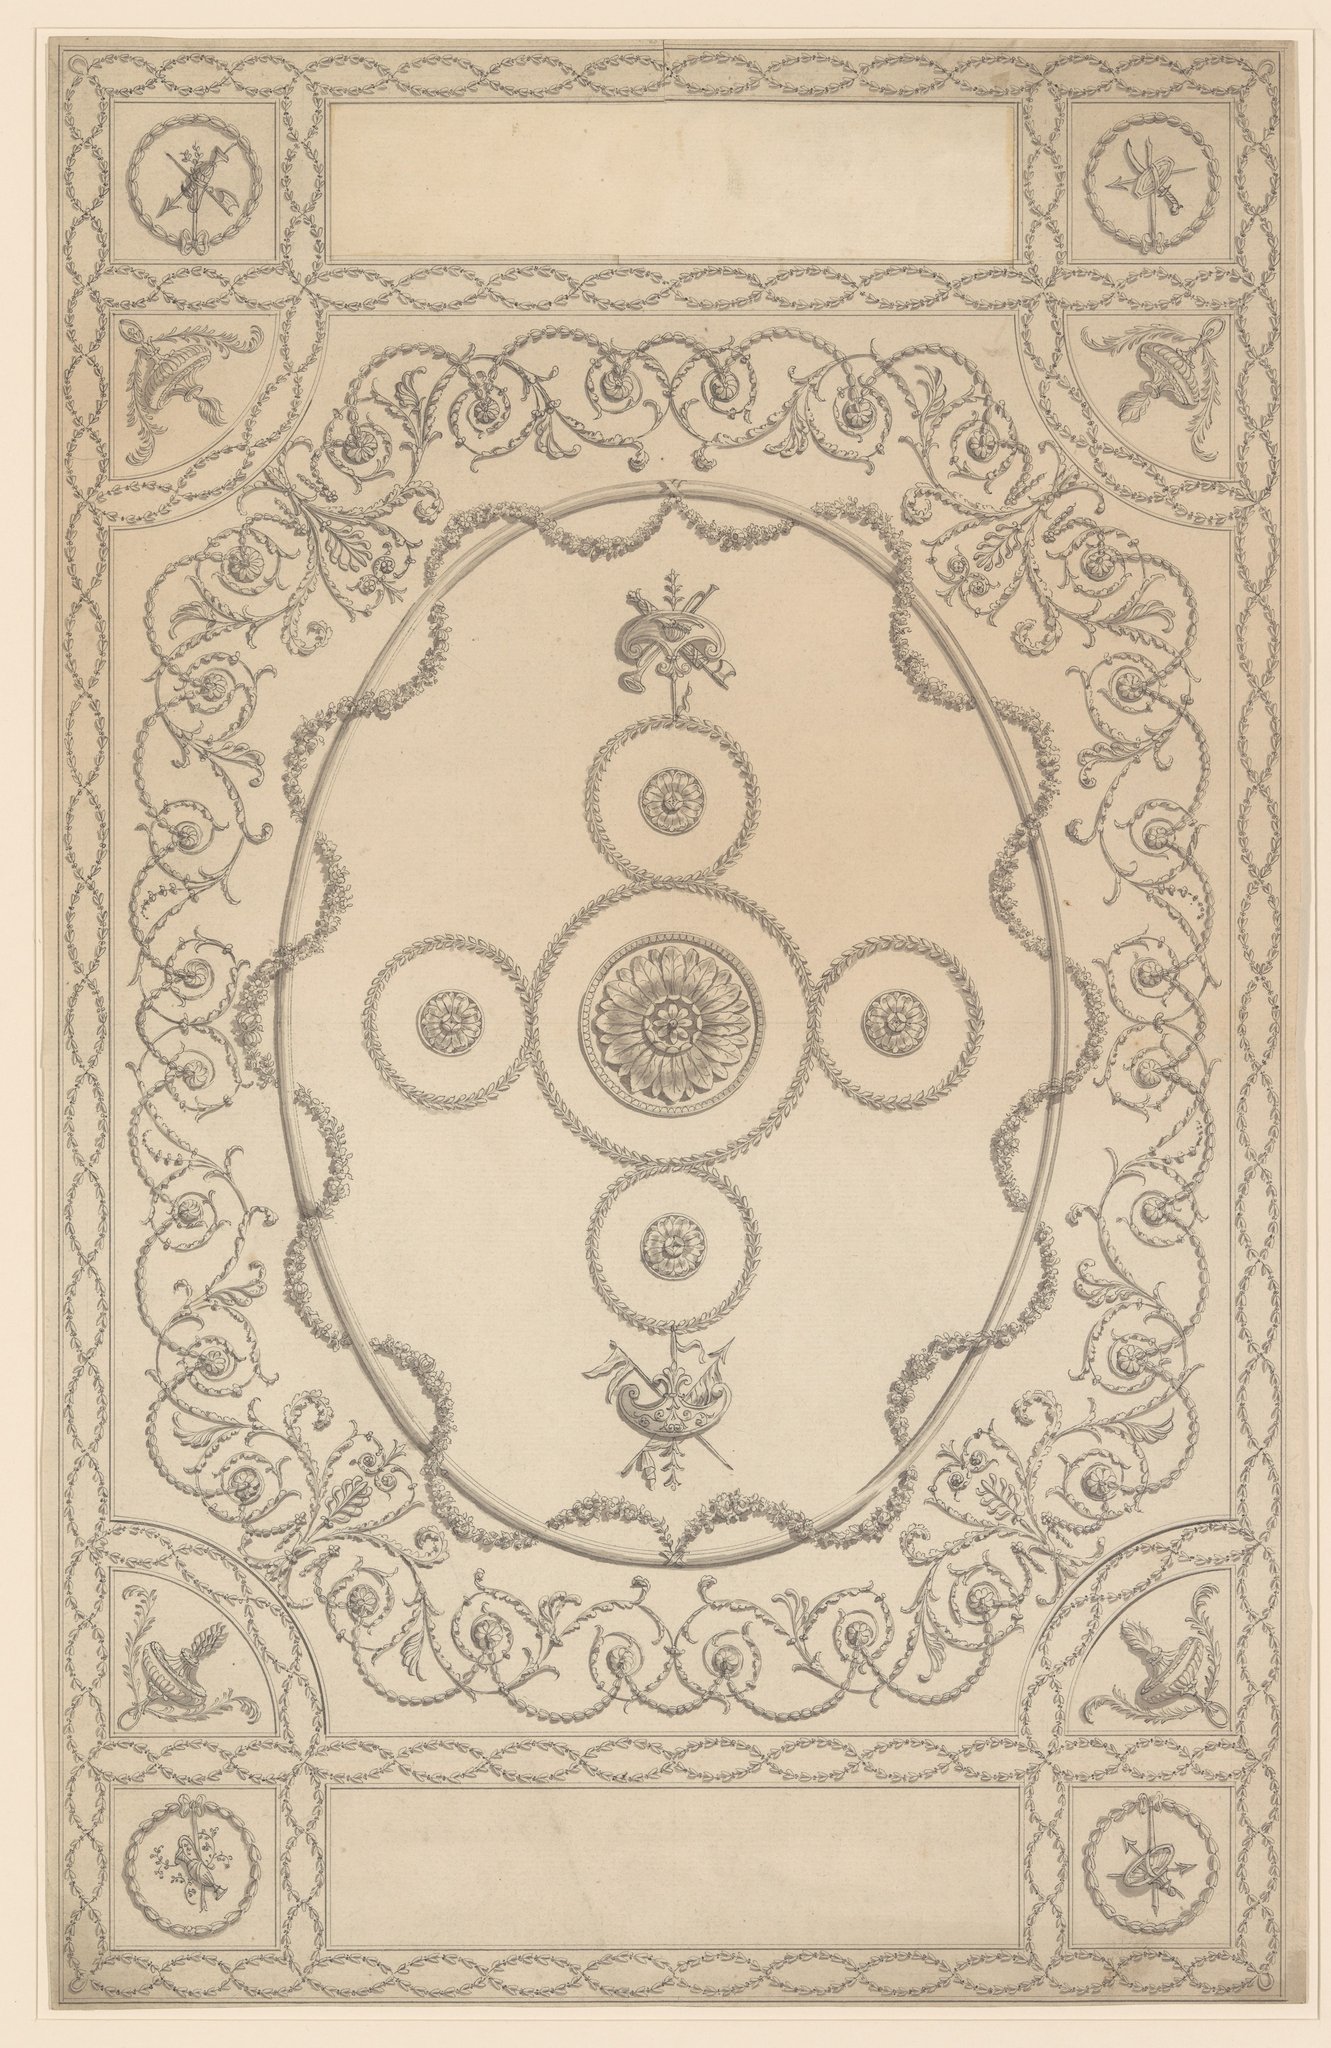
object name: drawing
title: Design for a Ceiling, an Oblong with an Oval Center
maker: sir william chambers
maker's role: artist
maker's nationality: british, born sweden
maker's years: 1723-1796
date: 1743-1796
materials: ink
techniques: brush, pen, wash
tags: architecture,ceilings